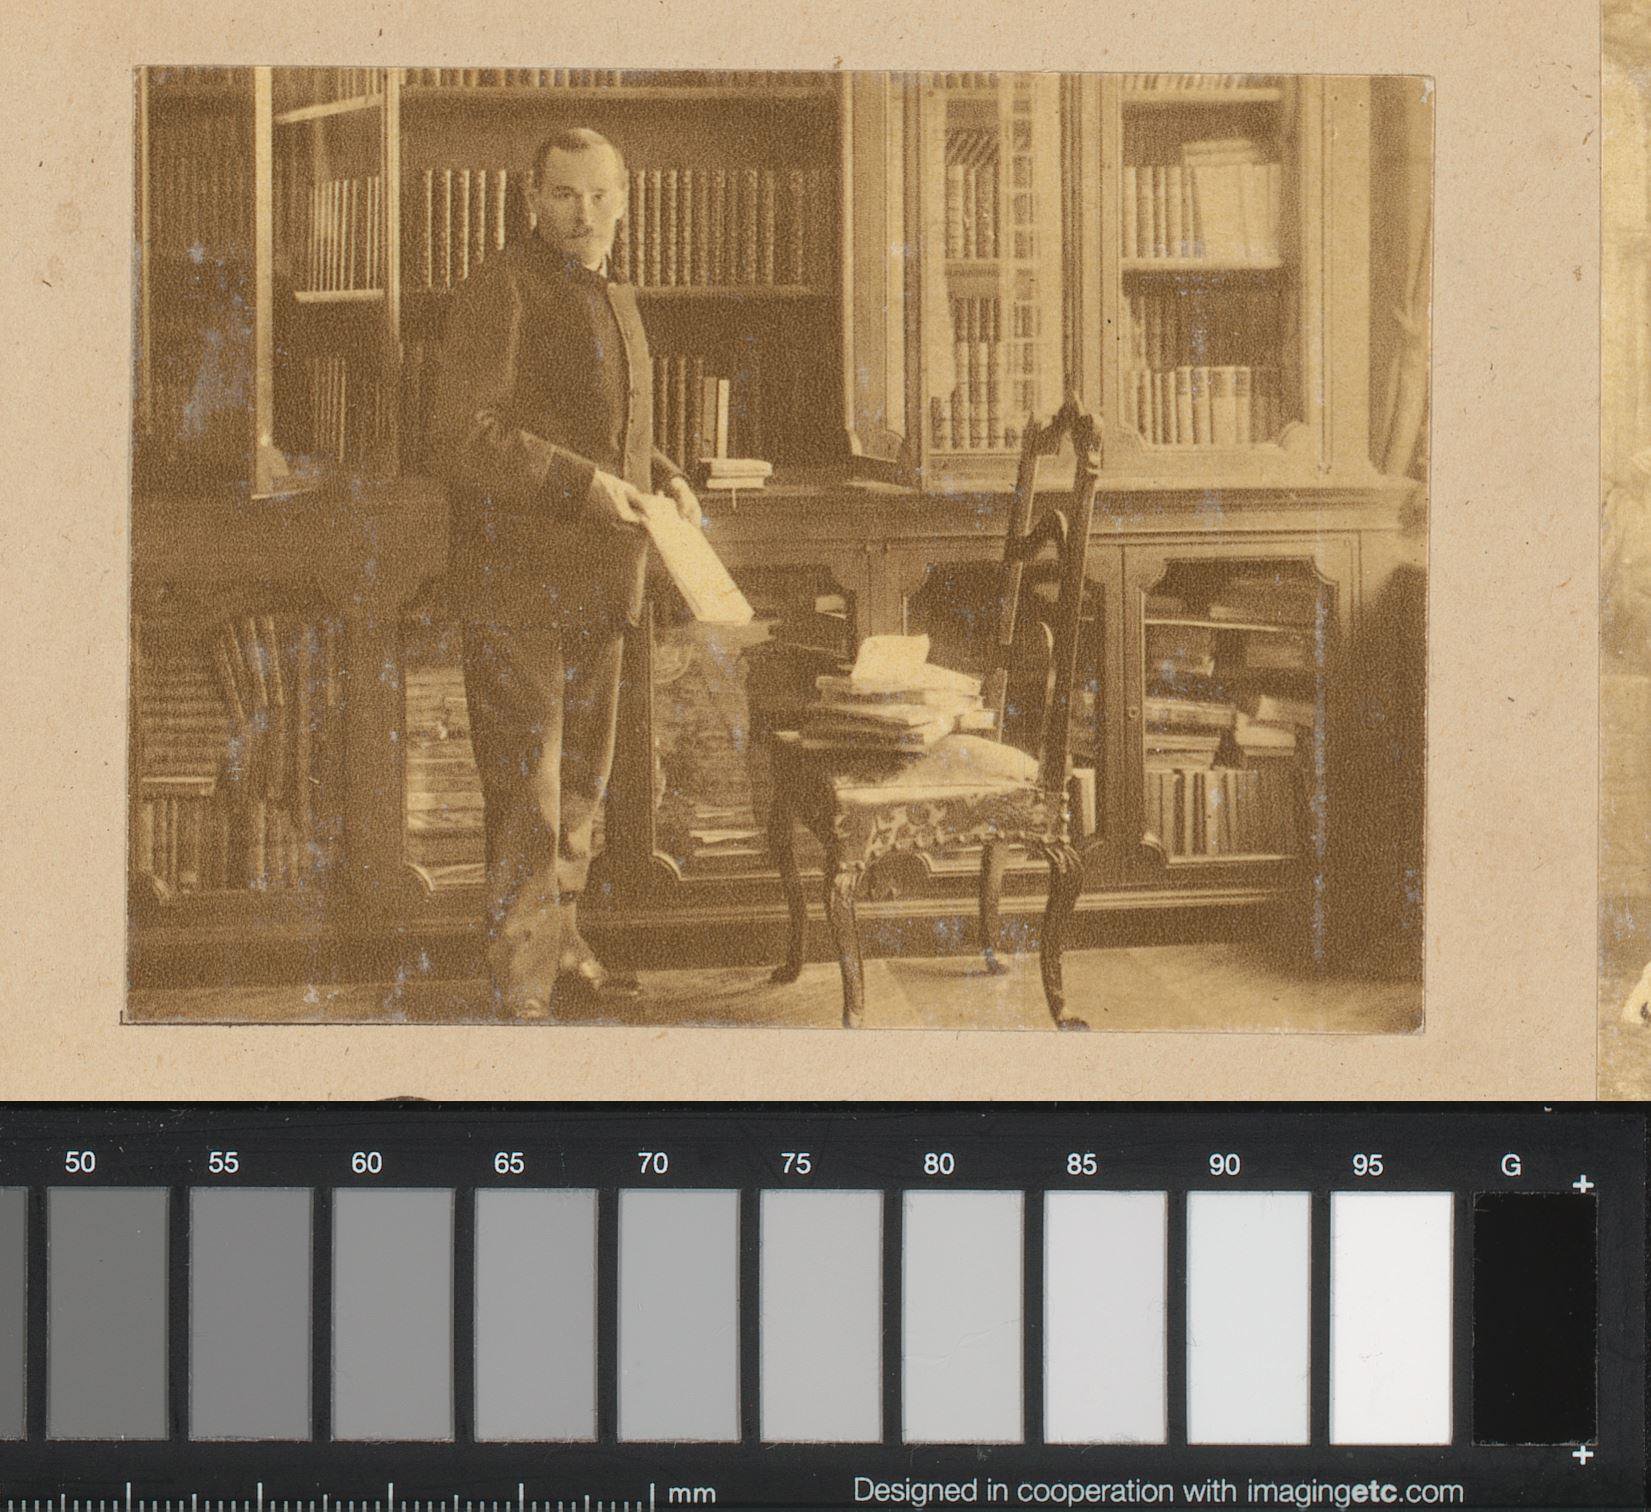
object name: photograph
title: Georges Ohnet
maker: Anonymous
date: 1883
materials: paper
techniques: rotogravure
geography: france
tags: writer, poet, author, france